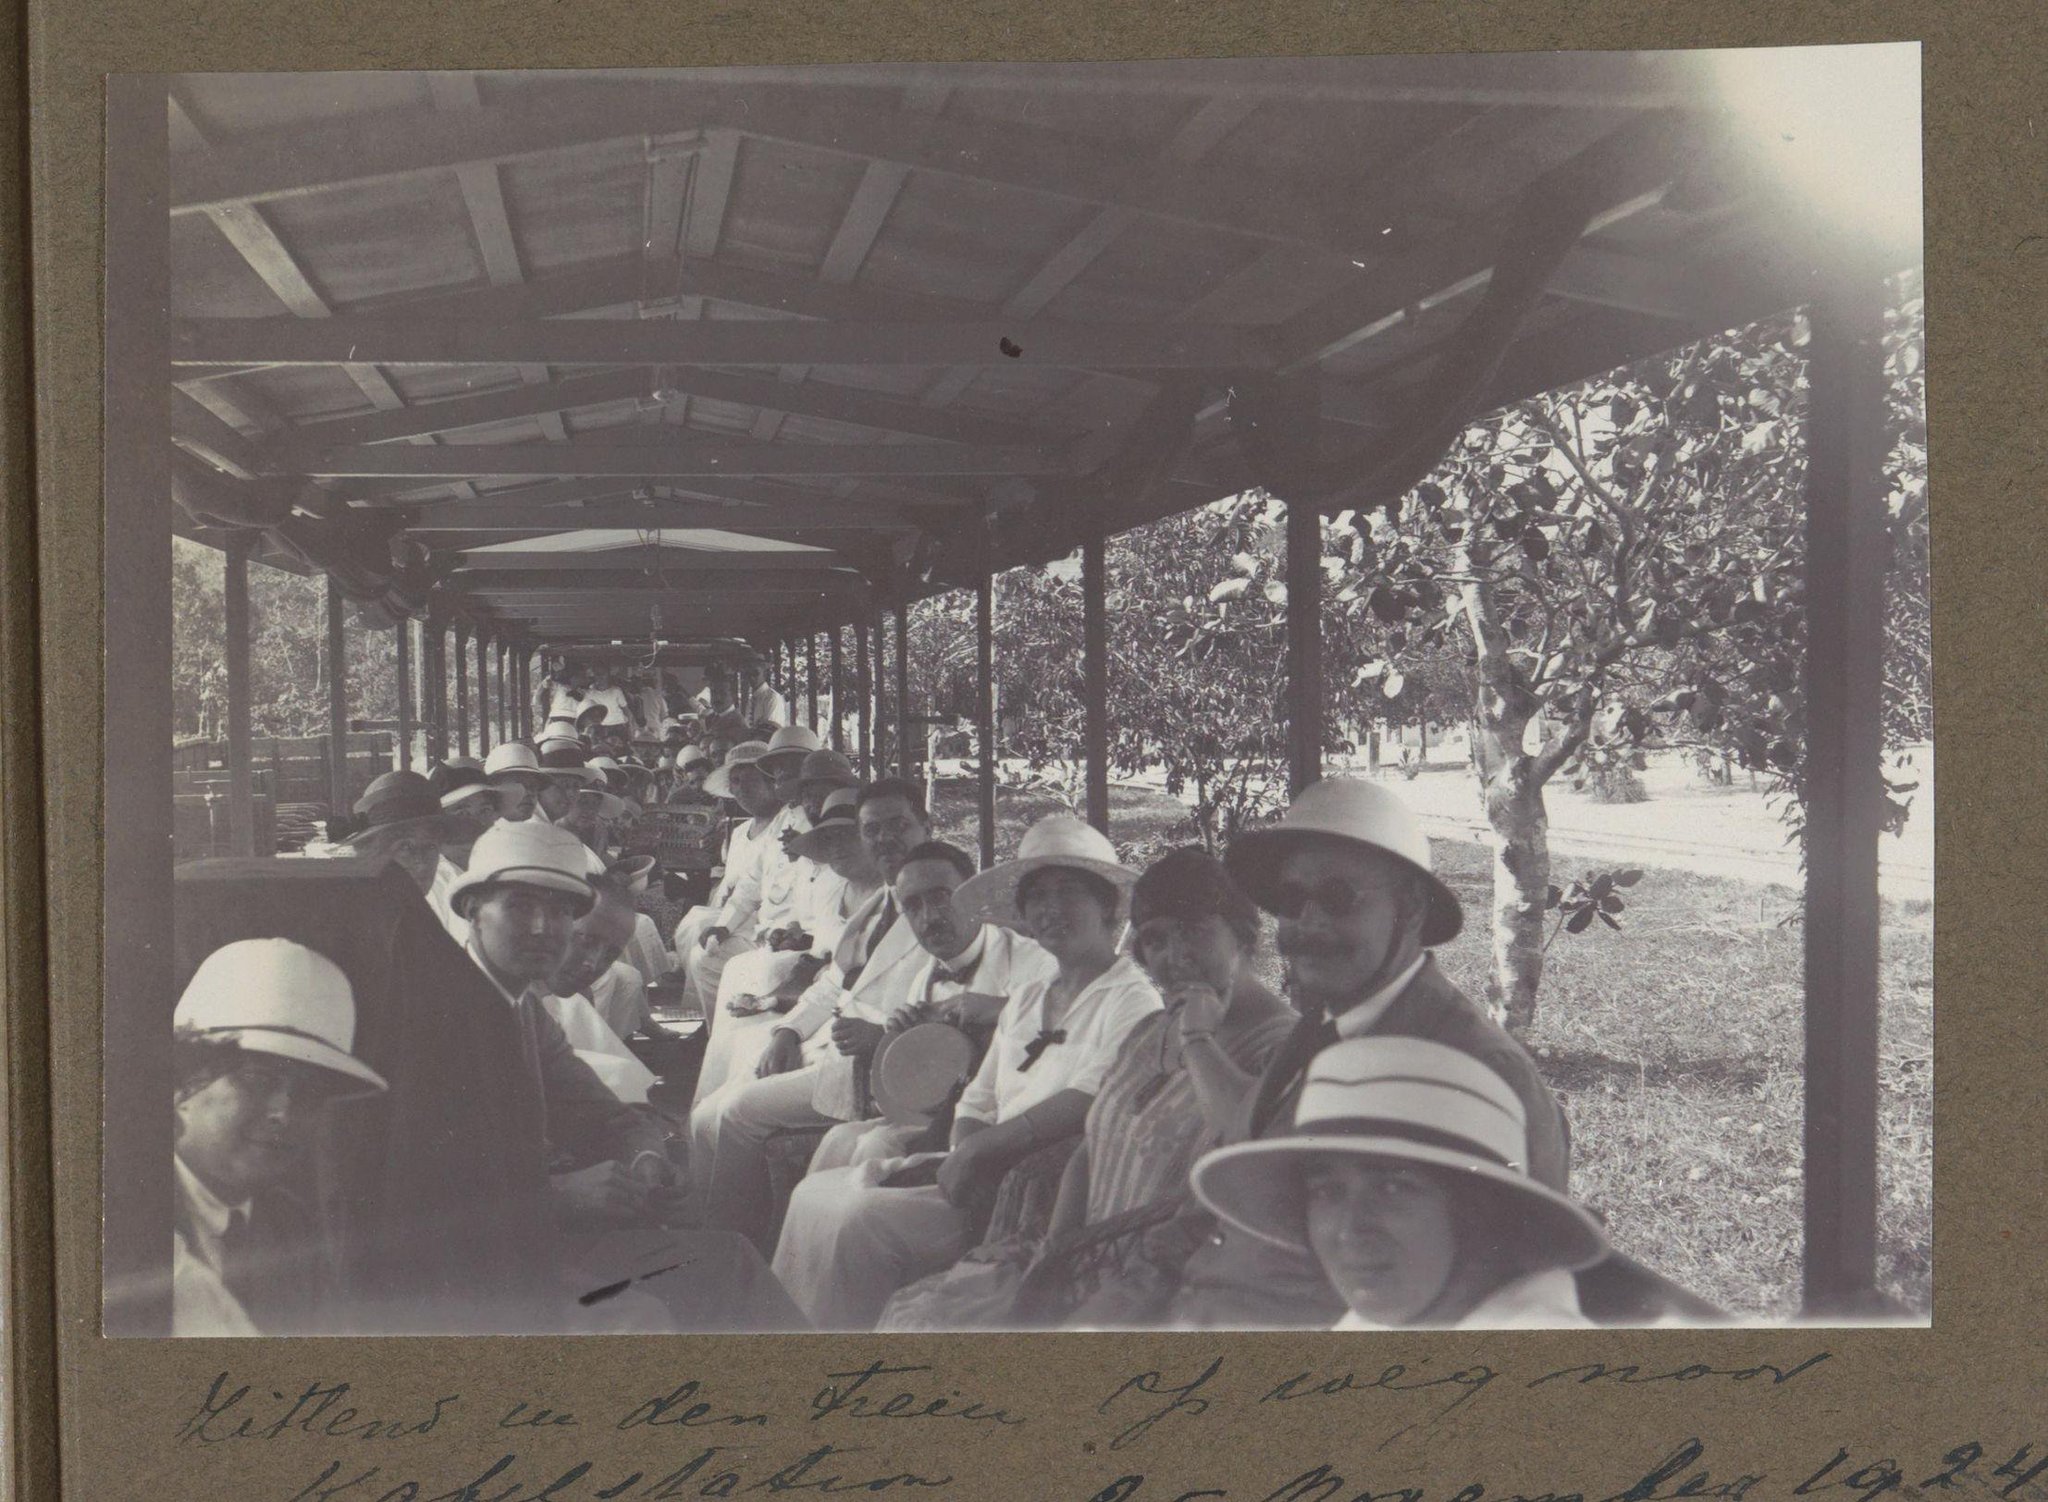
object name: photograph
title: Gezelschap in een treincoupé op de Lawaspoorlijn in Suriname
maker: Anonymous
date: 1924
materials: photographic support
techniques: gelatin silver print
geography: suriname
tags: adult woman, adult man, travelling; tourism, suriname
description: Onderdeel van fotoalbum van een onbekende Nederlandse familie met opnames van Suriname, Europa en Nederlands-Indië.